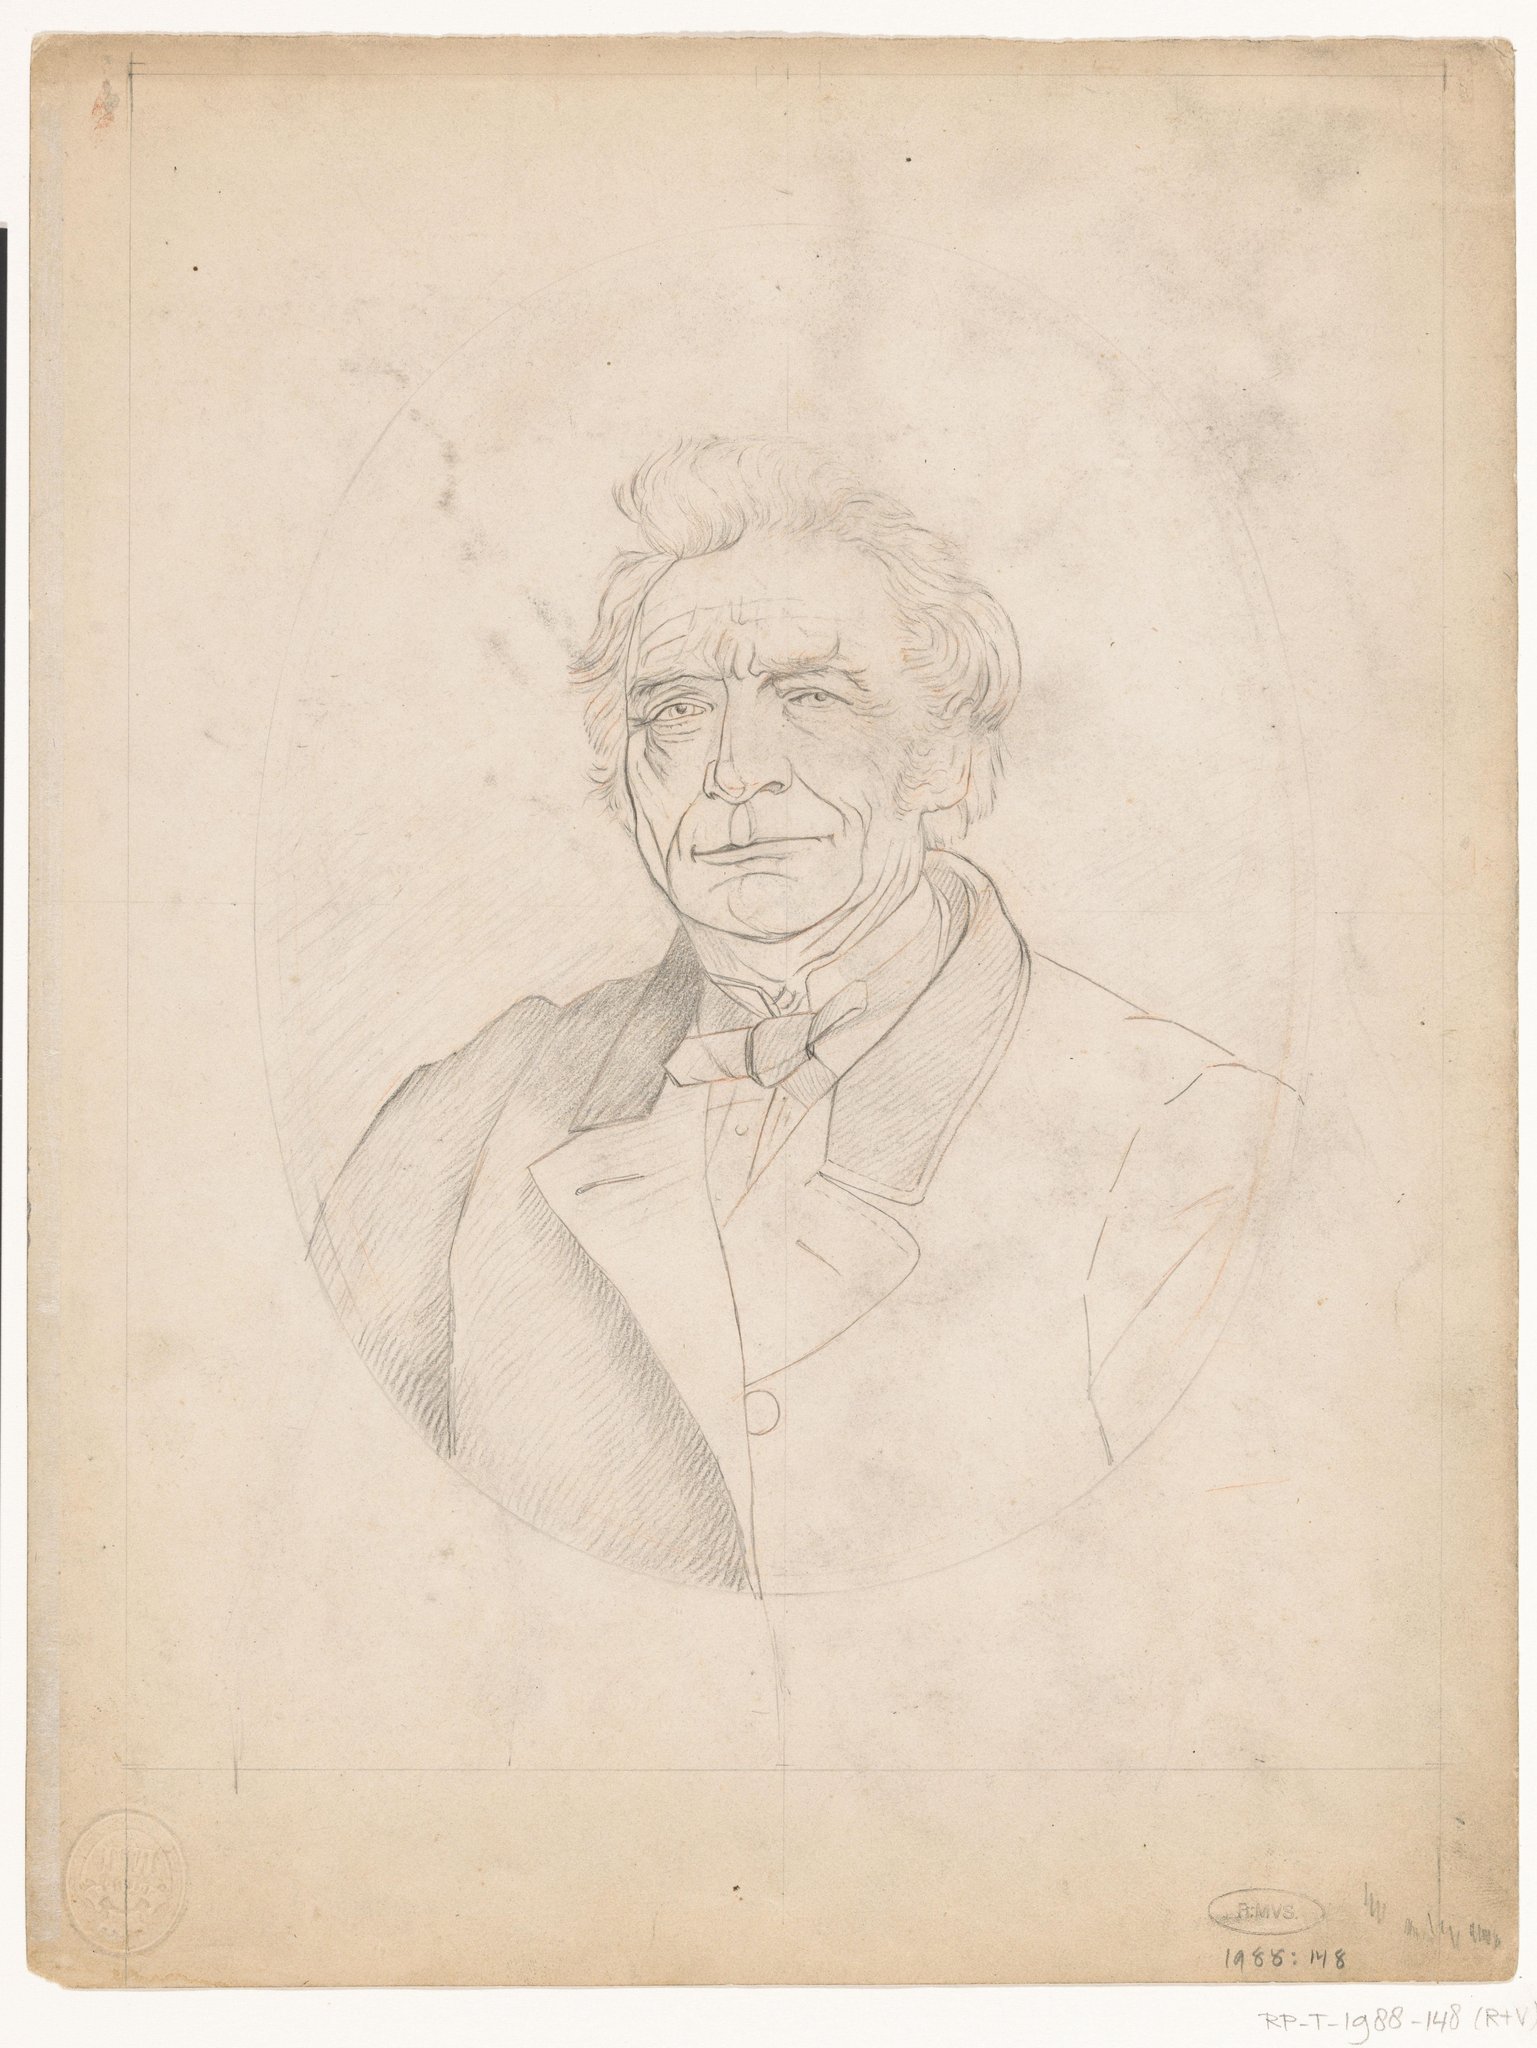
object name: drawing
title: Portret van een man, in ovaal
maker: Anonymous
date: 1800-1900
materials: chalk, paper, pencil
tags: anonymous historical person portrayed alone